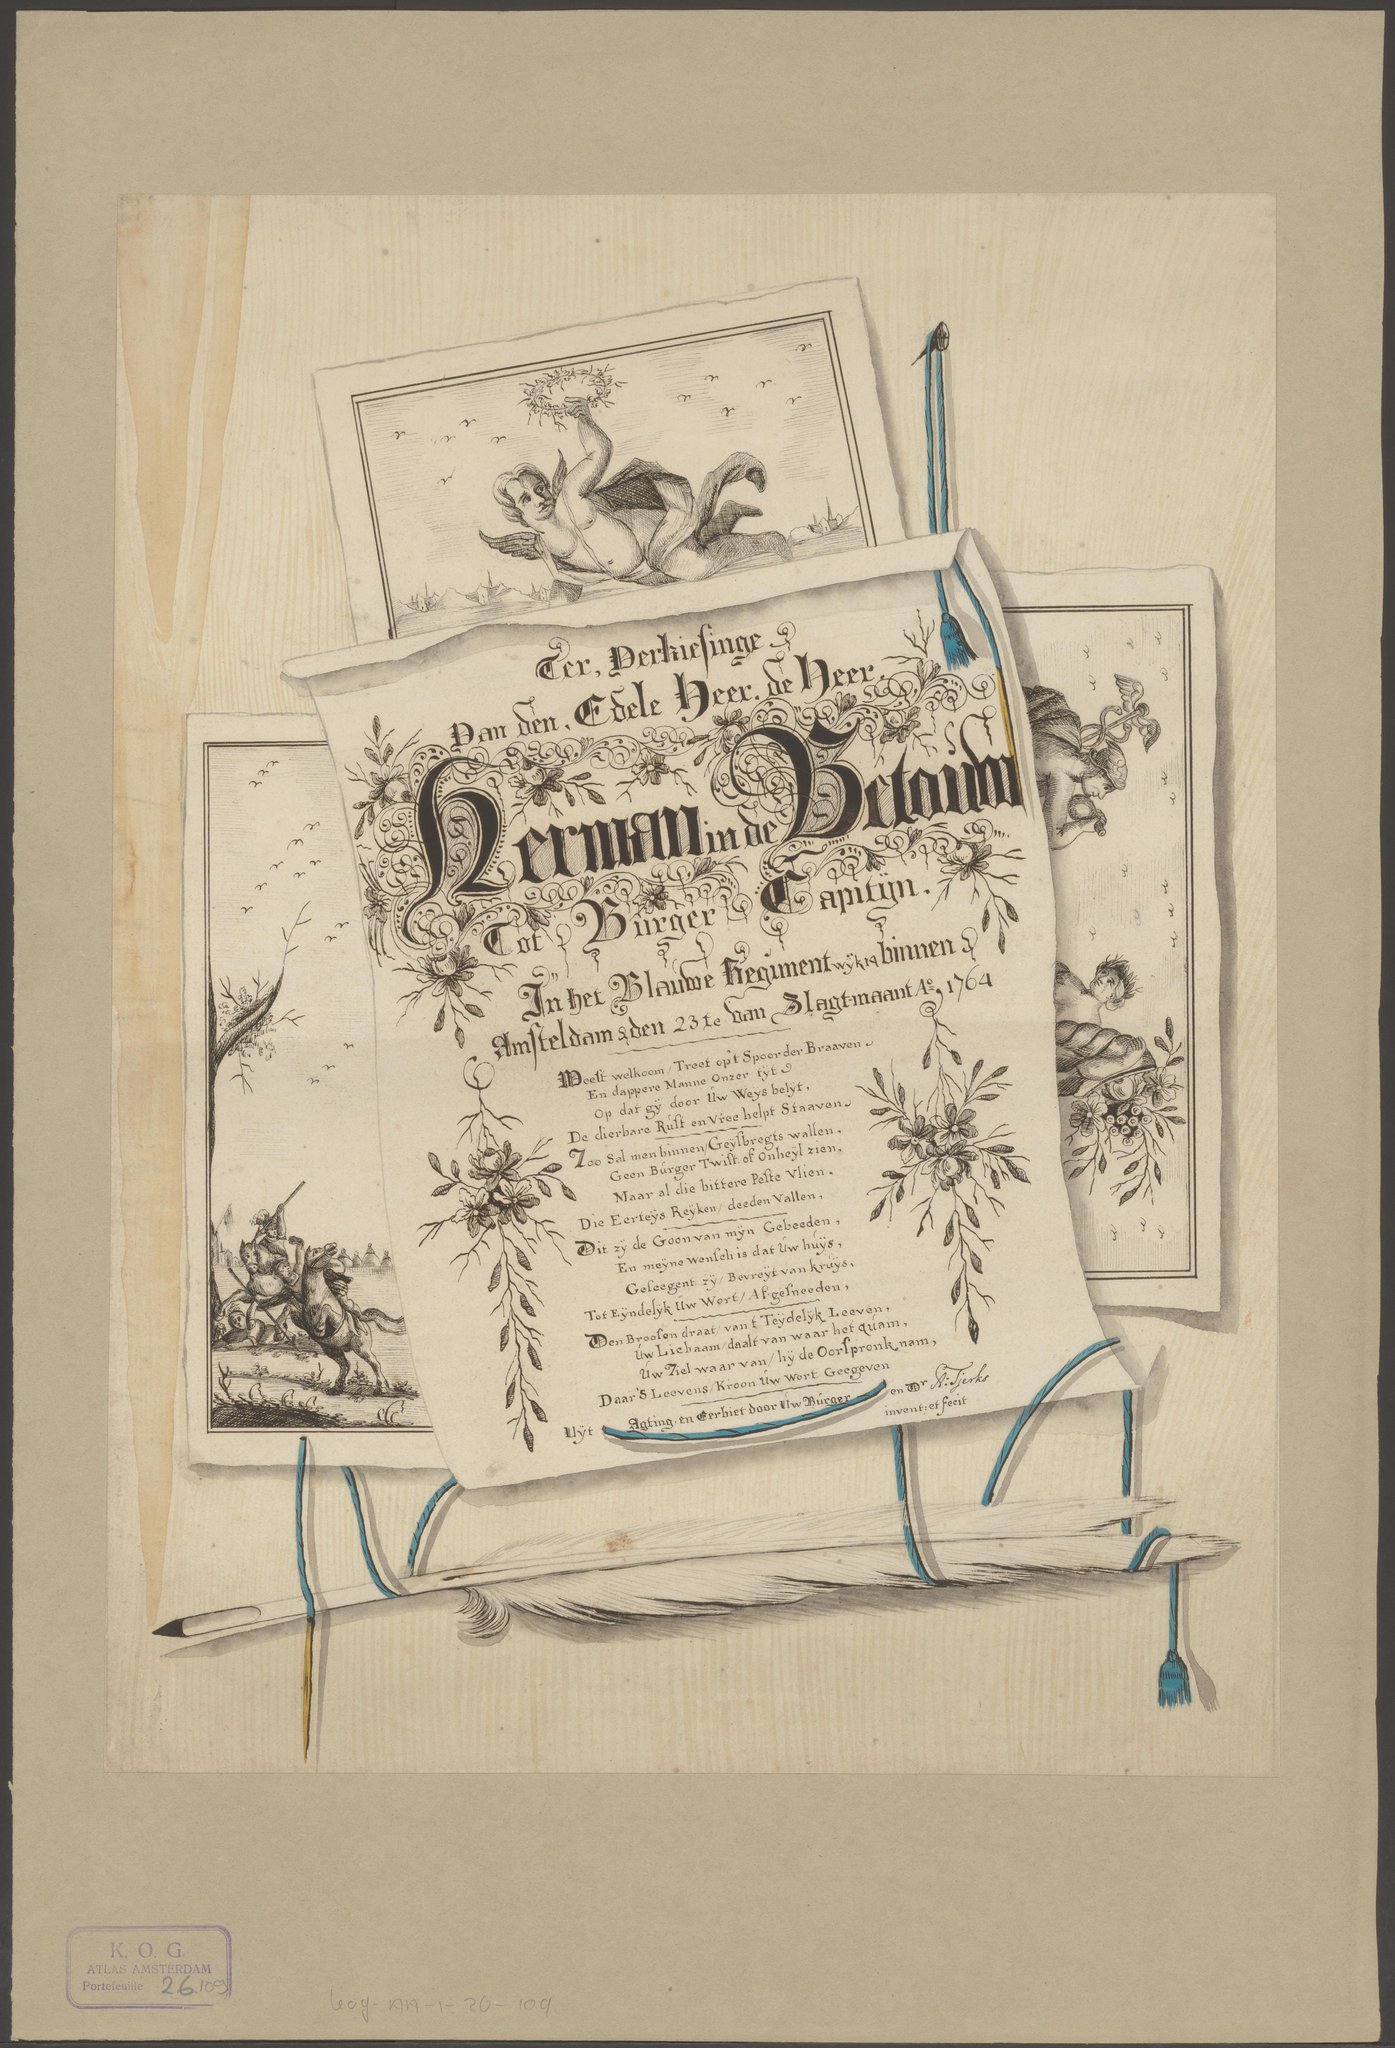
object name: drawing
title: Trompe-l'oeil met een brief, drie tekeningen en een ganzenveer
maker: abraham tjerks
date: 1764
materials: ink, paper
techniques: brush, pen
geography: northern netherlands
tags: amsterdam, drawing, sketch, cut flowers; nosegay, bunch of flowers, quill, cupids: 'amores', 'amoretti', 'putti'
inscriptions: collector's mark: Lugt 1641b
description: Gedicht naar aanleiding van de verkiezing van Herman in de Betouw tot kapitein van burgerwijk XIV te Amsterdam. Onderwerpsrubriek binnen de Atlas Amsterdam: Herinneringen aan de Schutterij.